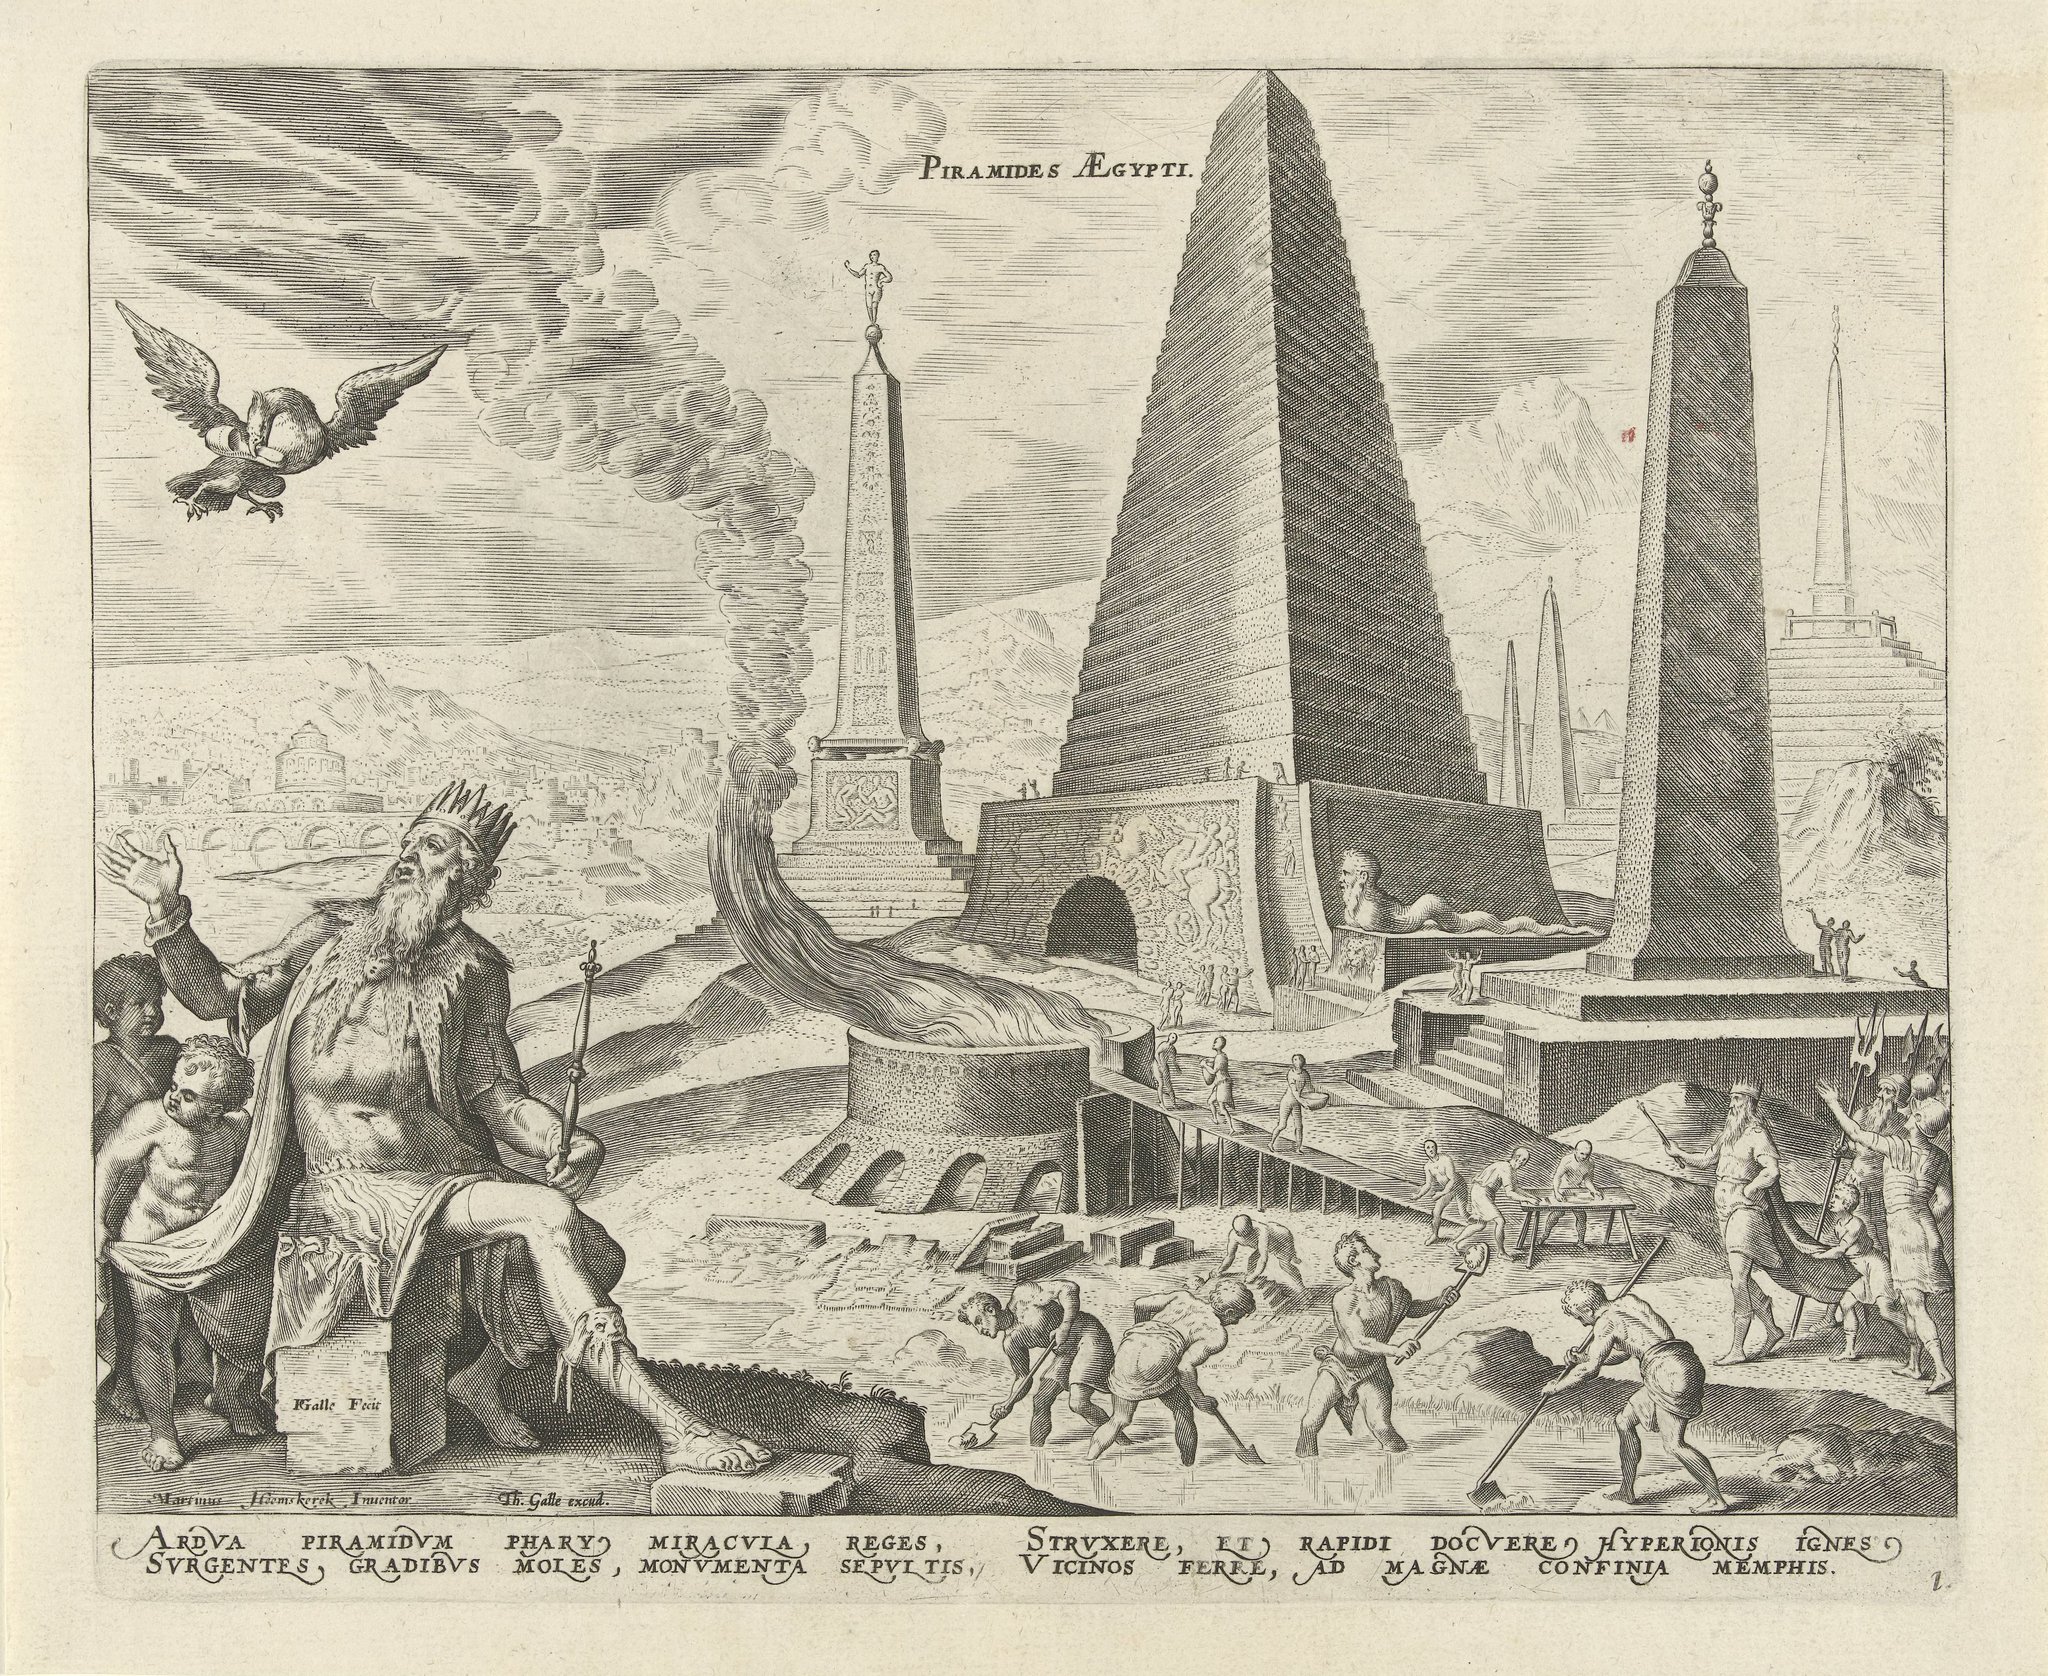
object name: print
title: Piramides Aegypti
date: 1572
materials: paper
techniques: engraving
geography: haarlem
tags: egyptian pyramids (wonder of the world), slavery; serfs and enslaved persons, pyramid (historical grave form), psammetichus, king of egypt, and the courtesan rhodopis; cupid assists her in putting on her sandal (while she was bathing one day an eagle carried away one of her sandals and dropped it near pharaoh, who started to look for its owner)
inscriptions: collector's mark: Lugt 2228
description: In de achtergrond Egyptische piramiden en obelisken. Tot slaaf gemaakte mannen scheppen klei uit de rivier, dat vervolgens in een brandende oven worden gebakken tot stenen voor de bouwwerken. In de voorgrond zit farao Psammetiches op een stenen blok. Hij kijkt naar een adelaar met een sandaal in zijn bek. Dit beeld verwijst naar een fabel van Aesopus over de relatie tussen Rhodopis, een jonge Egyptische vrouw, en de farao. De prent heeft een Latijns onderschrift en maakt deel uit van een serie over de acht wereldwonderen.